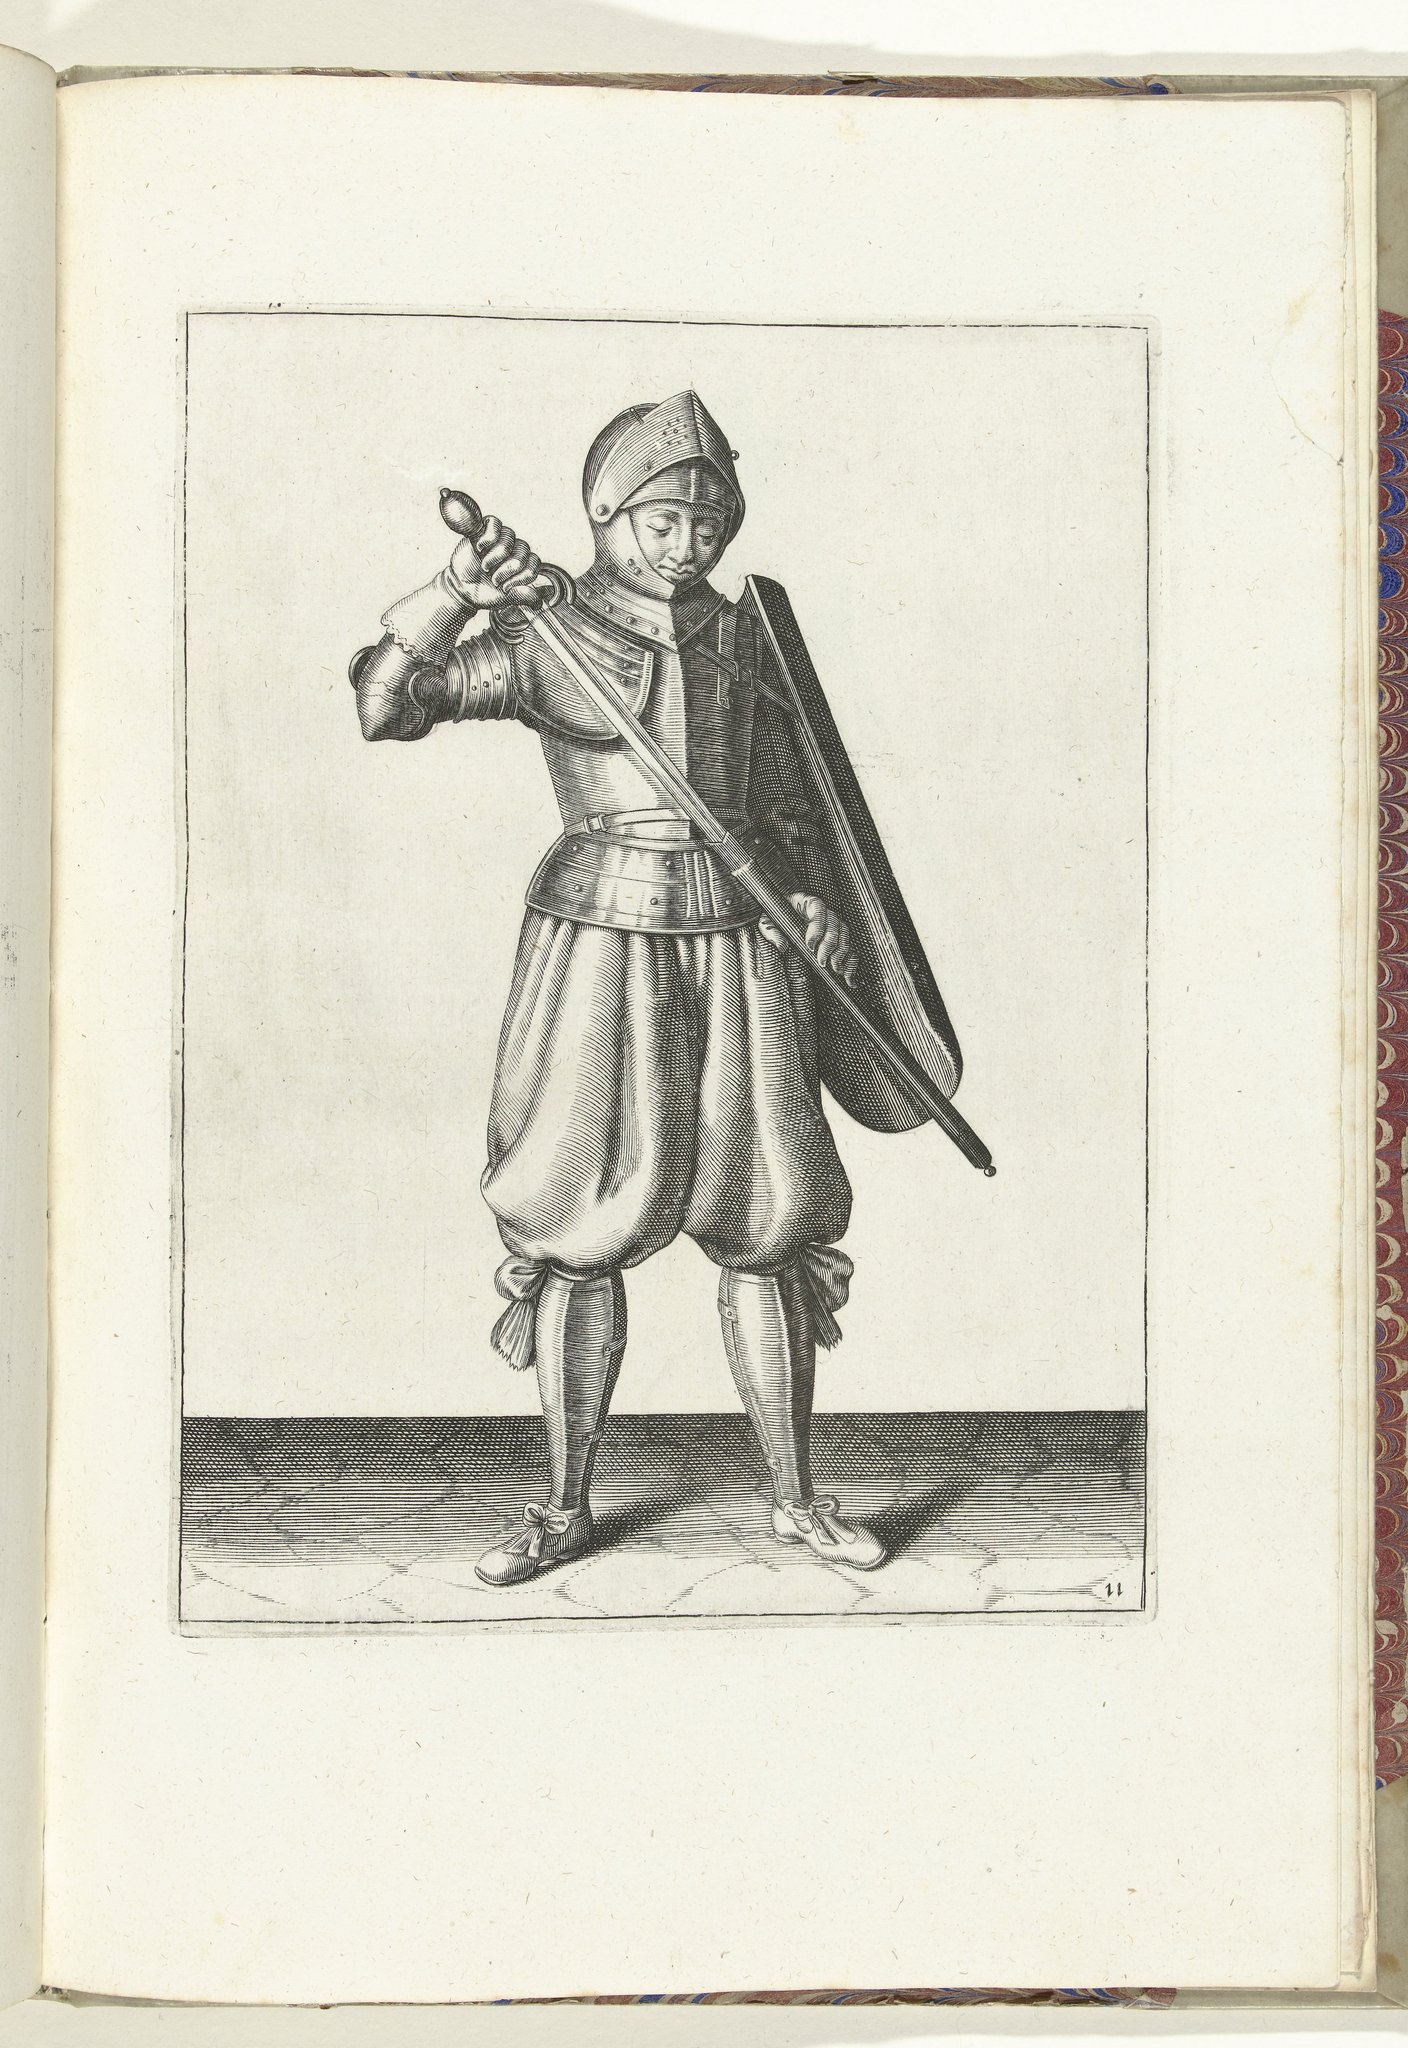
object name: print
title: De exercitie met de targe en rapier: de soldaat steekt zijn rapier terug in de schede, (nr. 11), 1618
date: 1616-1618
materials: paper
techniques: engraving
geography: northern netherlands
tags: maurice (prince of orange), handling of weapons ~ military training, weapons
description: Illustratie in: Adam van Breen, De Nassausche Wapen-Handelinge, van Schilt, Spies, Rappier ende Targe : beyde figuerlick afgebeelt, ende gestelt na de nieu ordening [van] ... Maurits van Nassau / Korte Onderwijsinge op de figuerlijcke af-beeldinghe belangende 'trecht ghebruyck van al 'tghene een Soldaet noodigh is in het handelen vande Targes met het Rappier, 's-Gravenhage, [Aert Meuris] 1618, plaat nr. 11. In het exemplaar in de collectie van de Rijksmuseum Research Library (326 F 22).